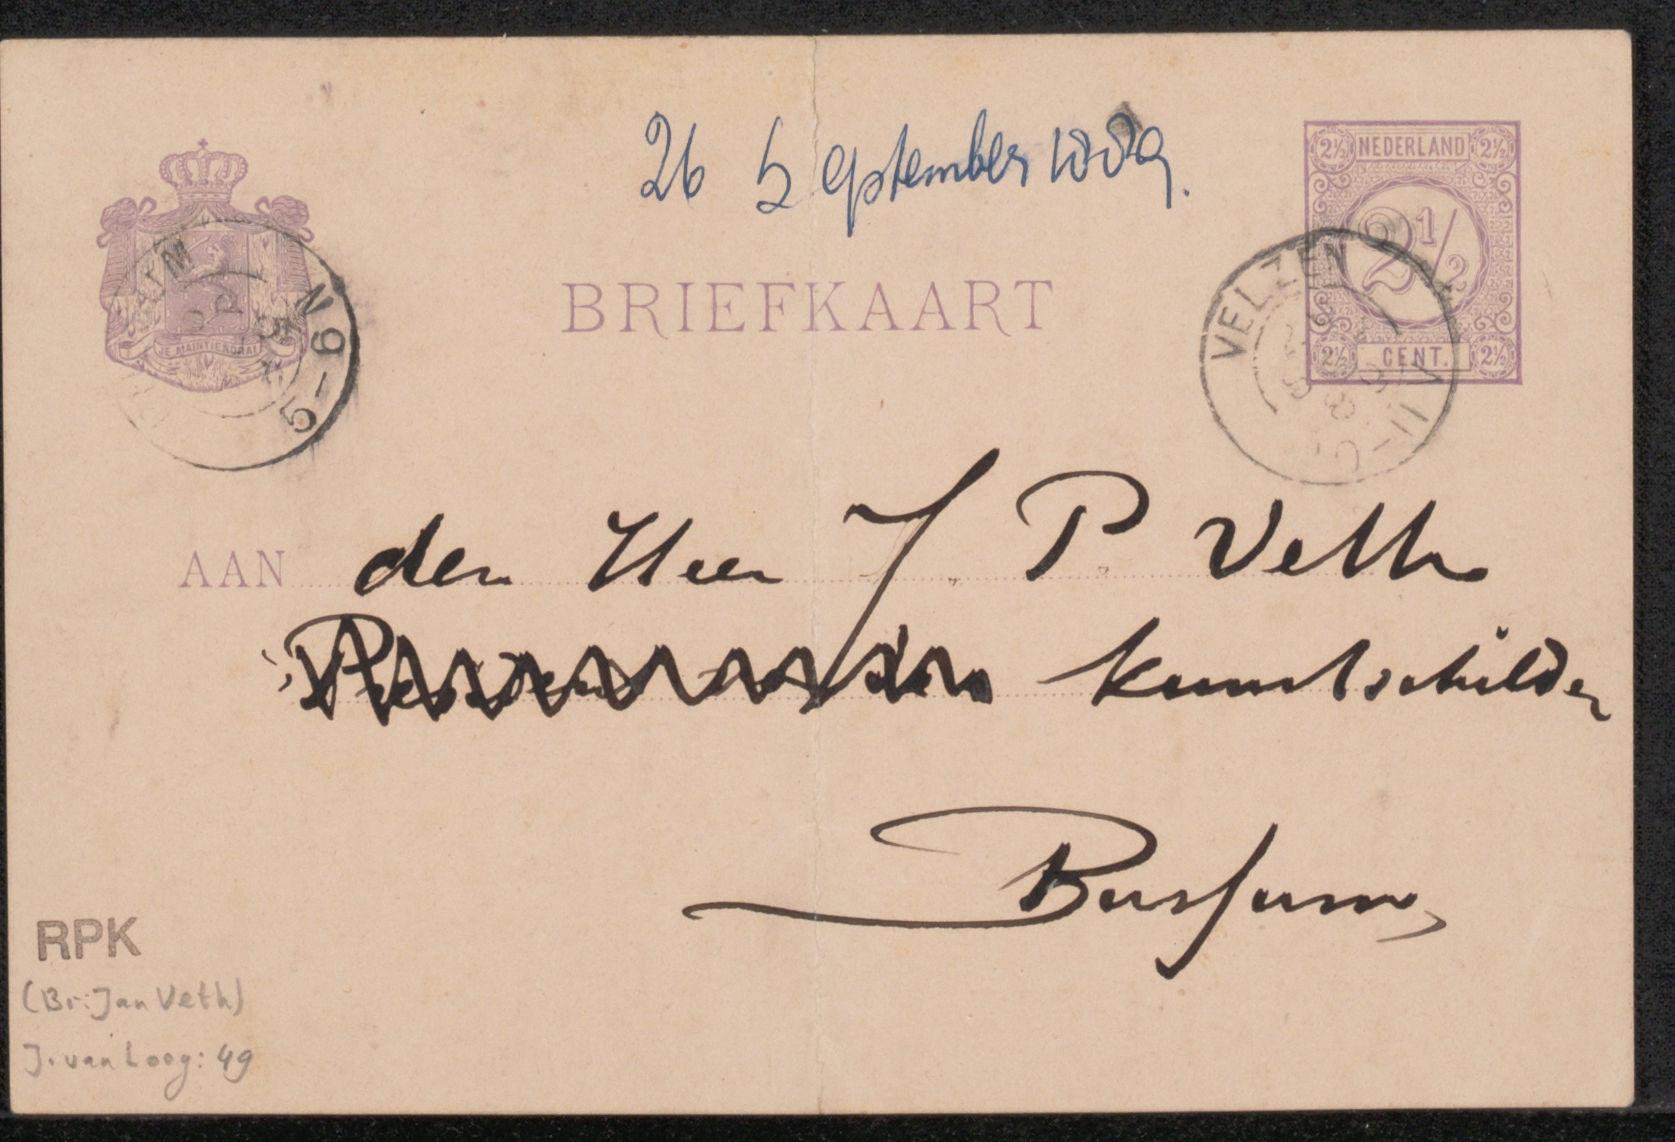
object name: postcard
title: Briefkaart aan Jan Veth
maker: jac van looij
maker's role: draughtsman, painter, print maker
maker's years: 1855-1930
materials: cardboard, ink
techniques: pen, writing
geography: velzen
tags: designer, jan veth, maurits van der valk, samuel jessurun de mesquita, amsterdam, painter, print maker, draughtsman, eduard karsen, giovanni segantini, james abbott mcneill whistler, deventer, elisabeth van vloten, photography, cinematography, painting (including book-illumination, miniature-painting), workshop, studio of the artist (in general), the hague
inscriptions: collector's mark: ‘RPK’